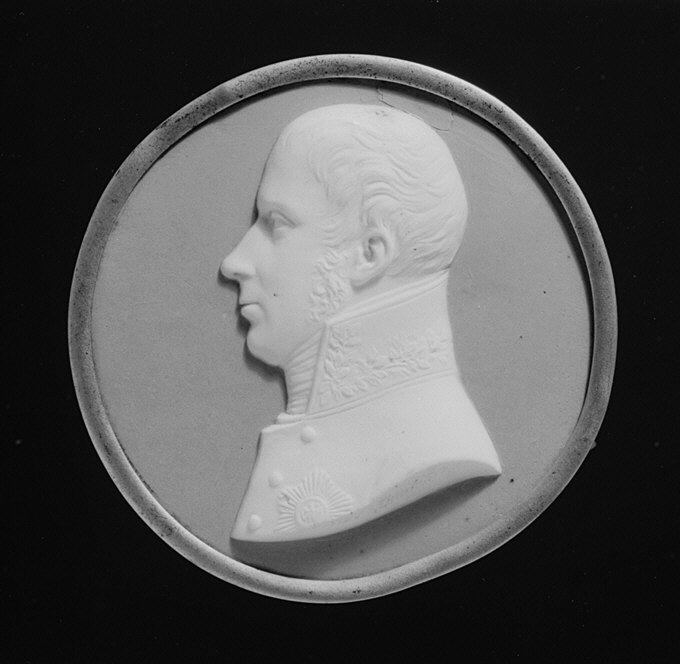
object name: medallion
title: Baron Wilhelm von Humboldt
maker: sèvres manufactory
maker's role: manufactory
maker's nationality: french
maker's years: 1740-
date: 1767-1833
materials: biscuit, paste, porcelain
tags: men,profiles